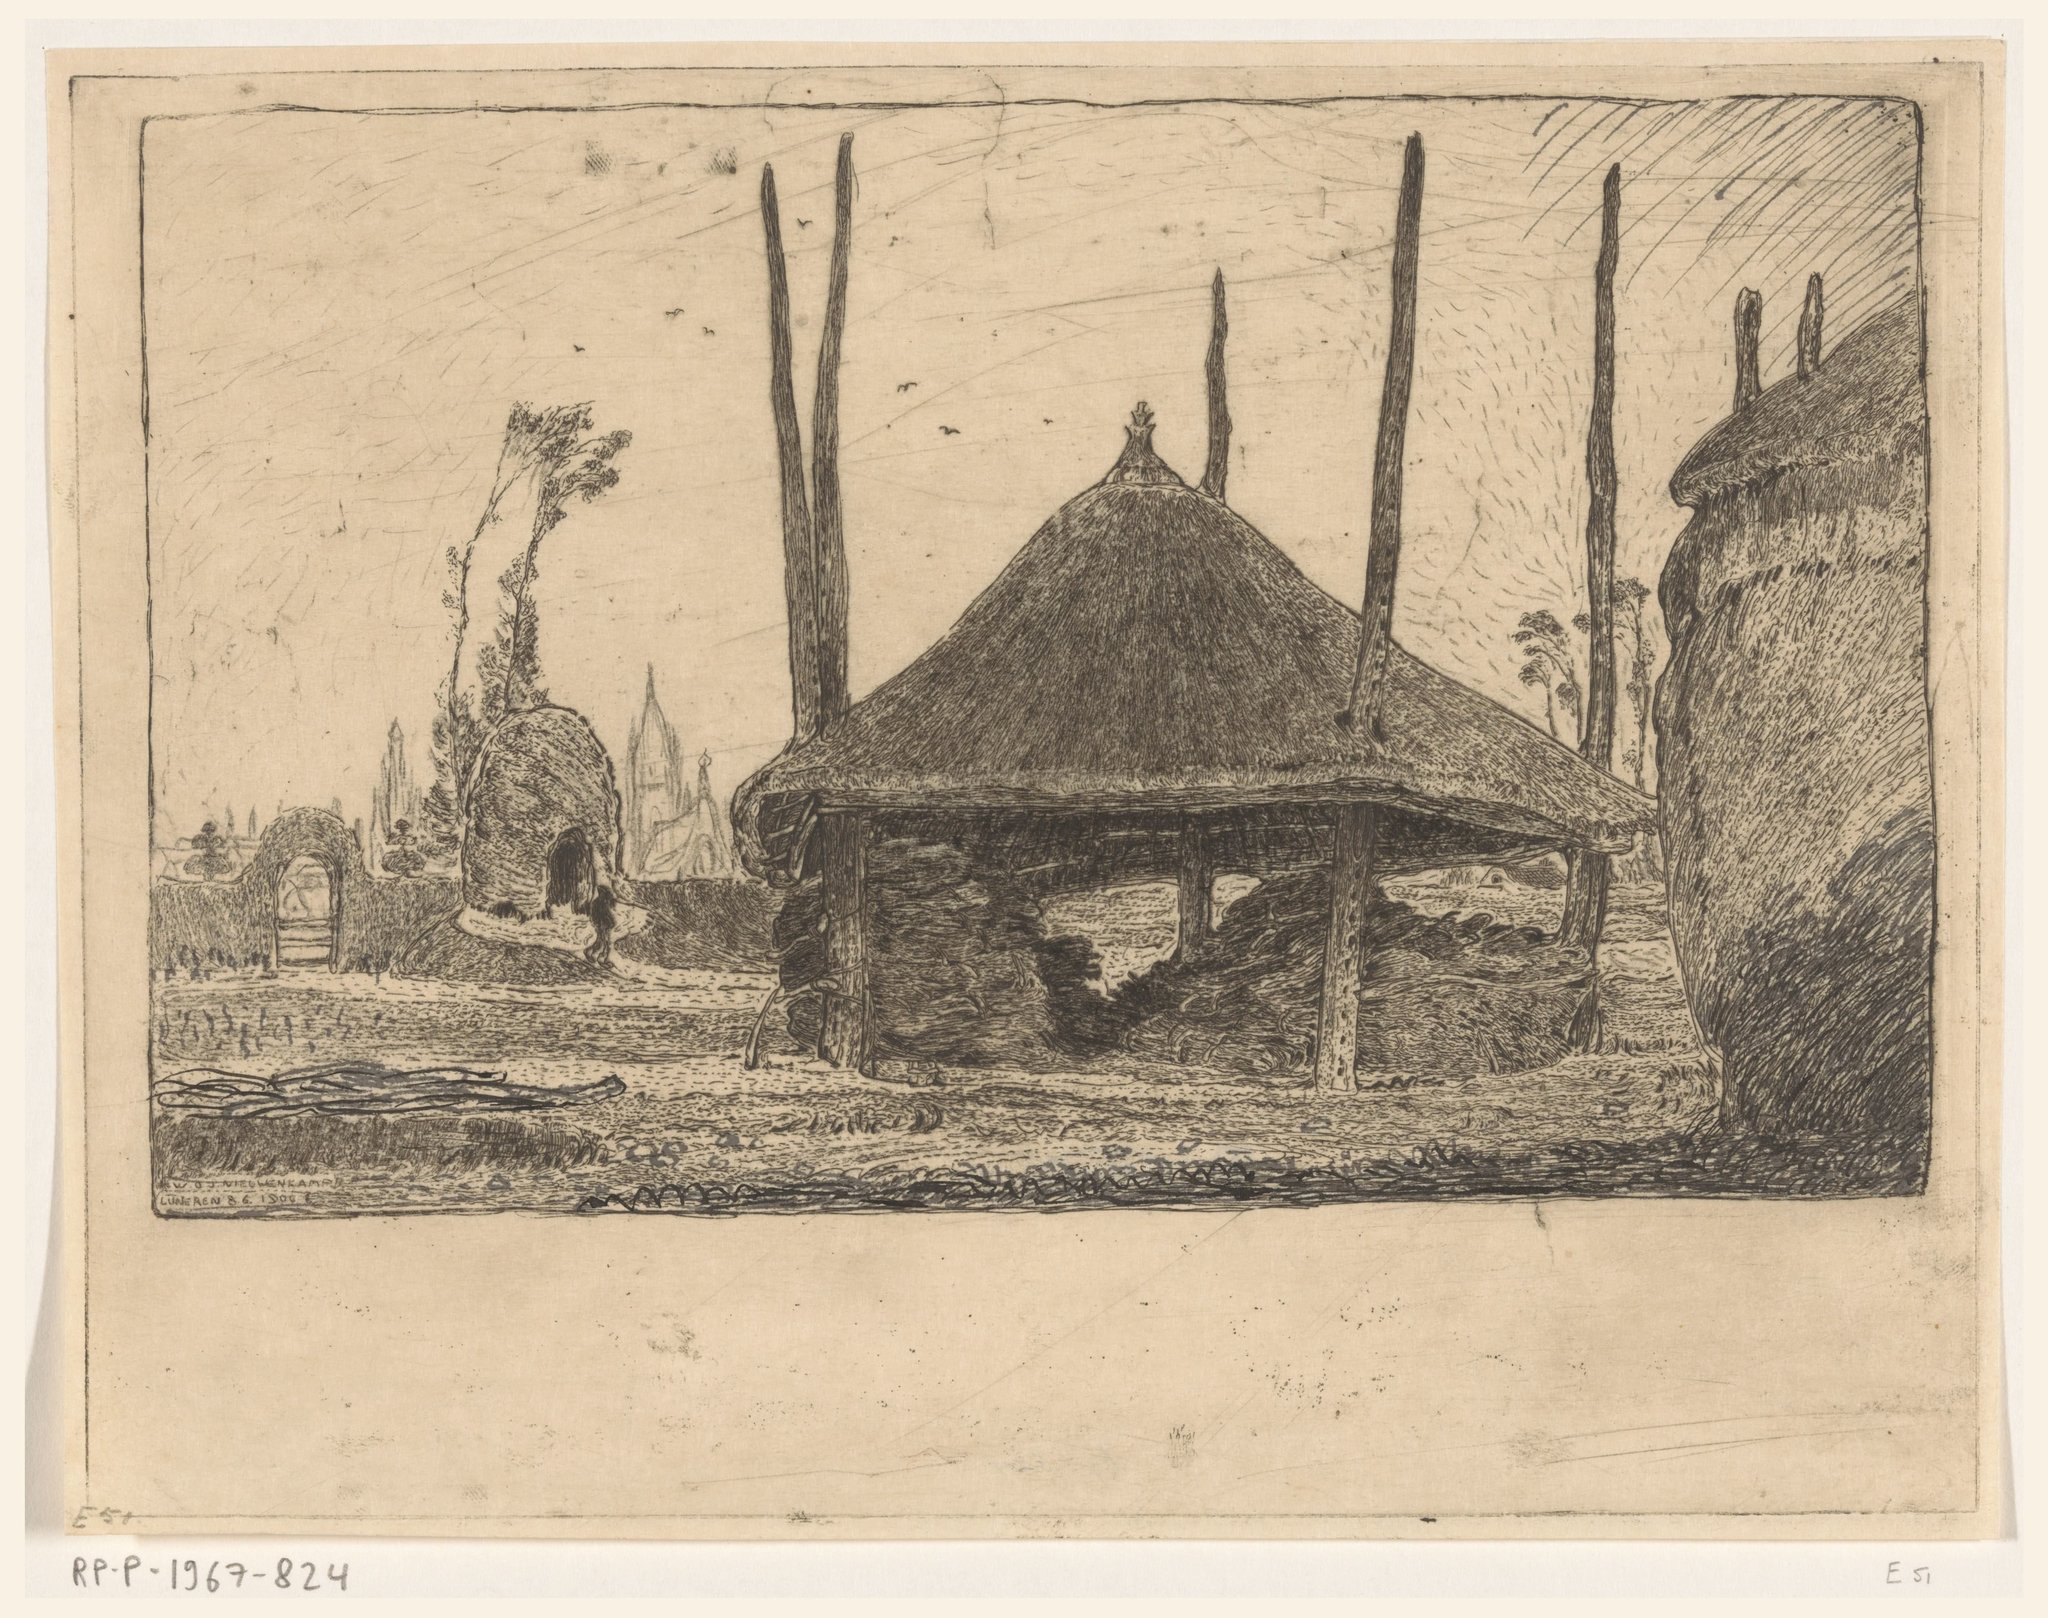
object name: print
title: Hooibergen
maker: wijnand otto jan nieuwenkamp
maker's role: draughtsman, print maker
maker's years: 1874-1950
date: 1900-1906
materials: paper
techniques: intaglio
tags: barn, agricultural products and by-products: hay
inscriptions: collector's mark: Lugt 2760, collector's mark: Lugt 2228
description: In het midden een hooischuur met brandhout, rechts een gedeelte van ene hooischuur met hooi. Op de achtergrond een heg met een poort en een prieel.